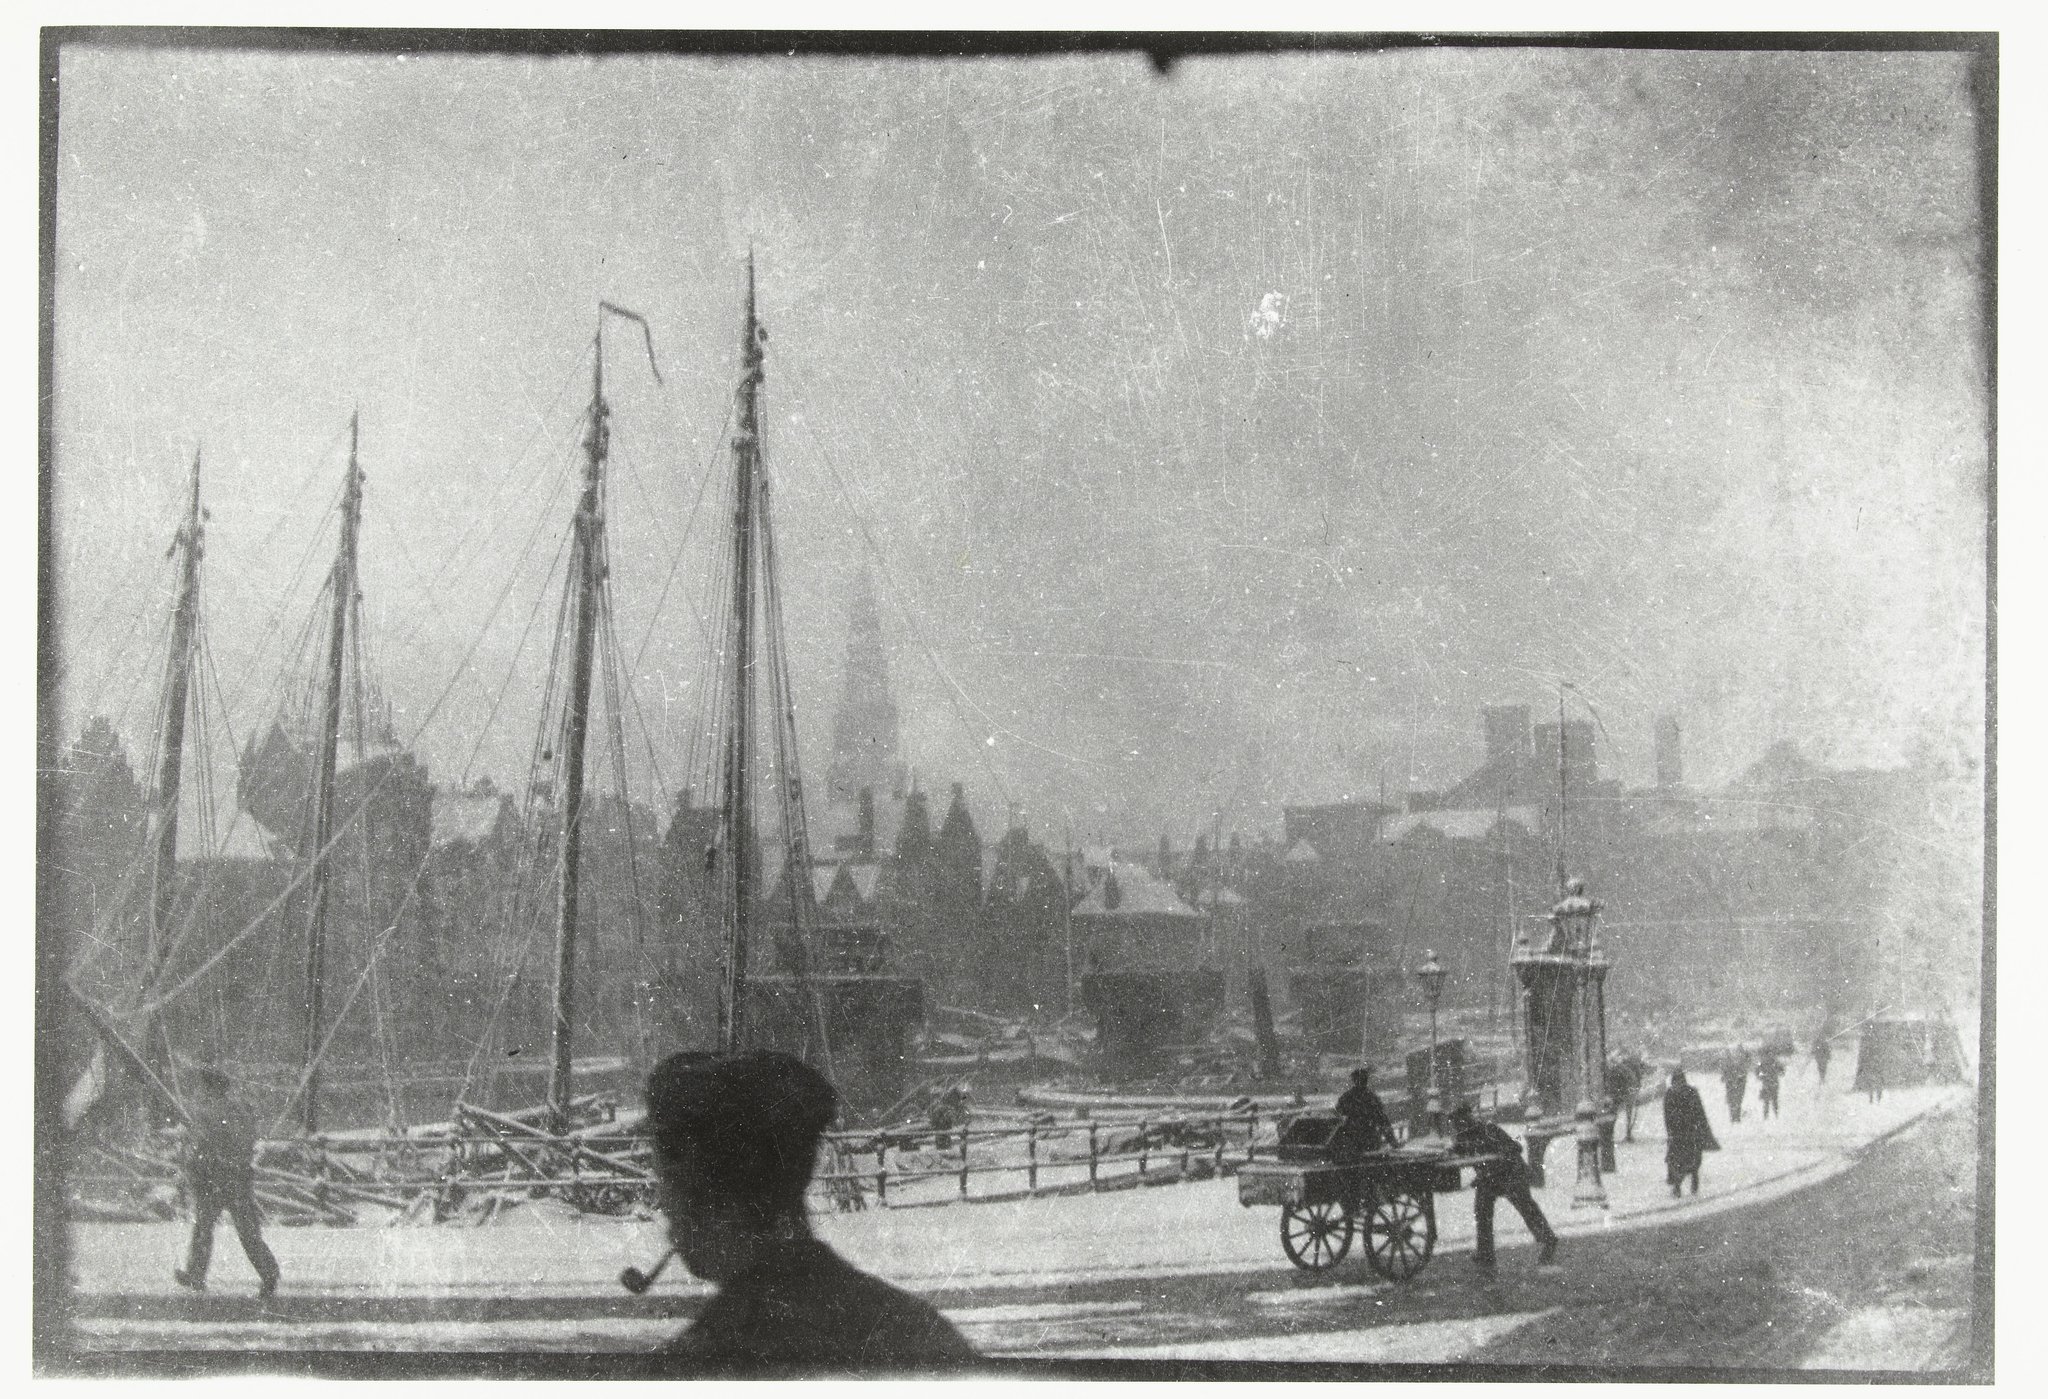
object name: photograph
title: Sneeuwgezicht over het Damrak in Amsterdam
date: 1890-1910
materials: paper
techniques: photography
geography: amsterdam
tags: damrak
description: Moderne afdruk van negatief BR 658 (collectie RKD)..